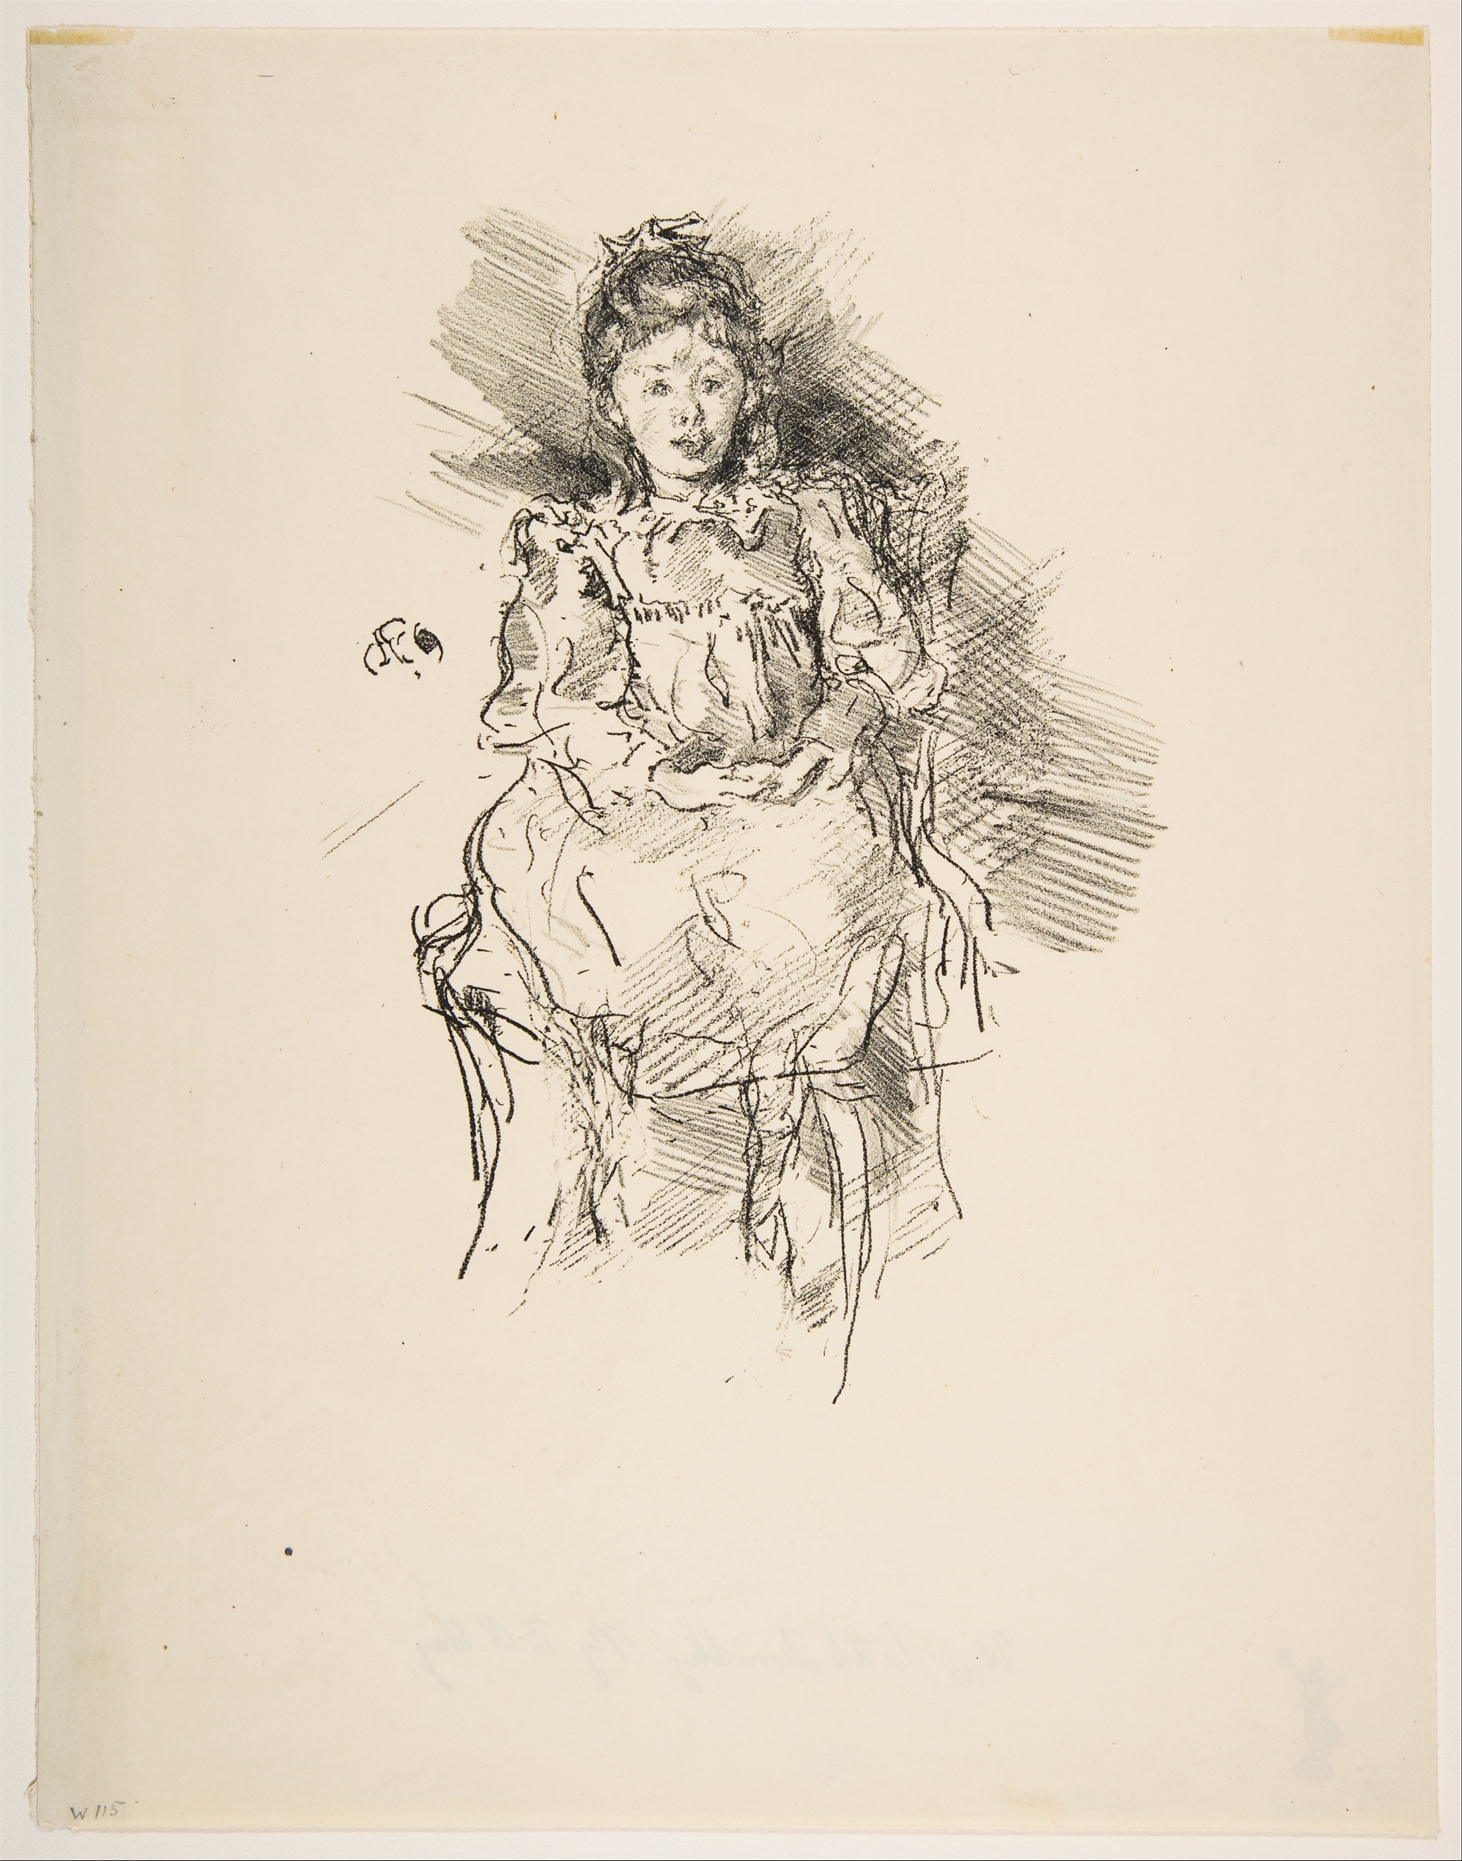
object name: print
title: Little Dorothy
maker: james mcneill whistler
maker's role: artist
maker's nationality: american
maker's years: 1834-1903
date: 1896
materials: ink, paper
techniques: printing, lithography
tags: girls